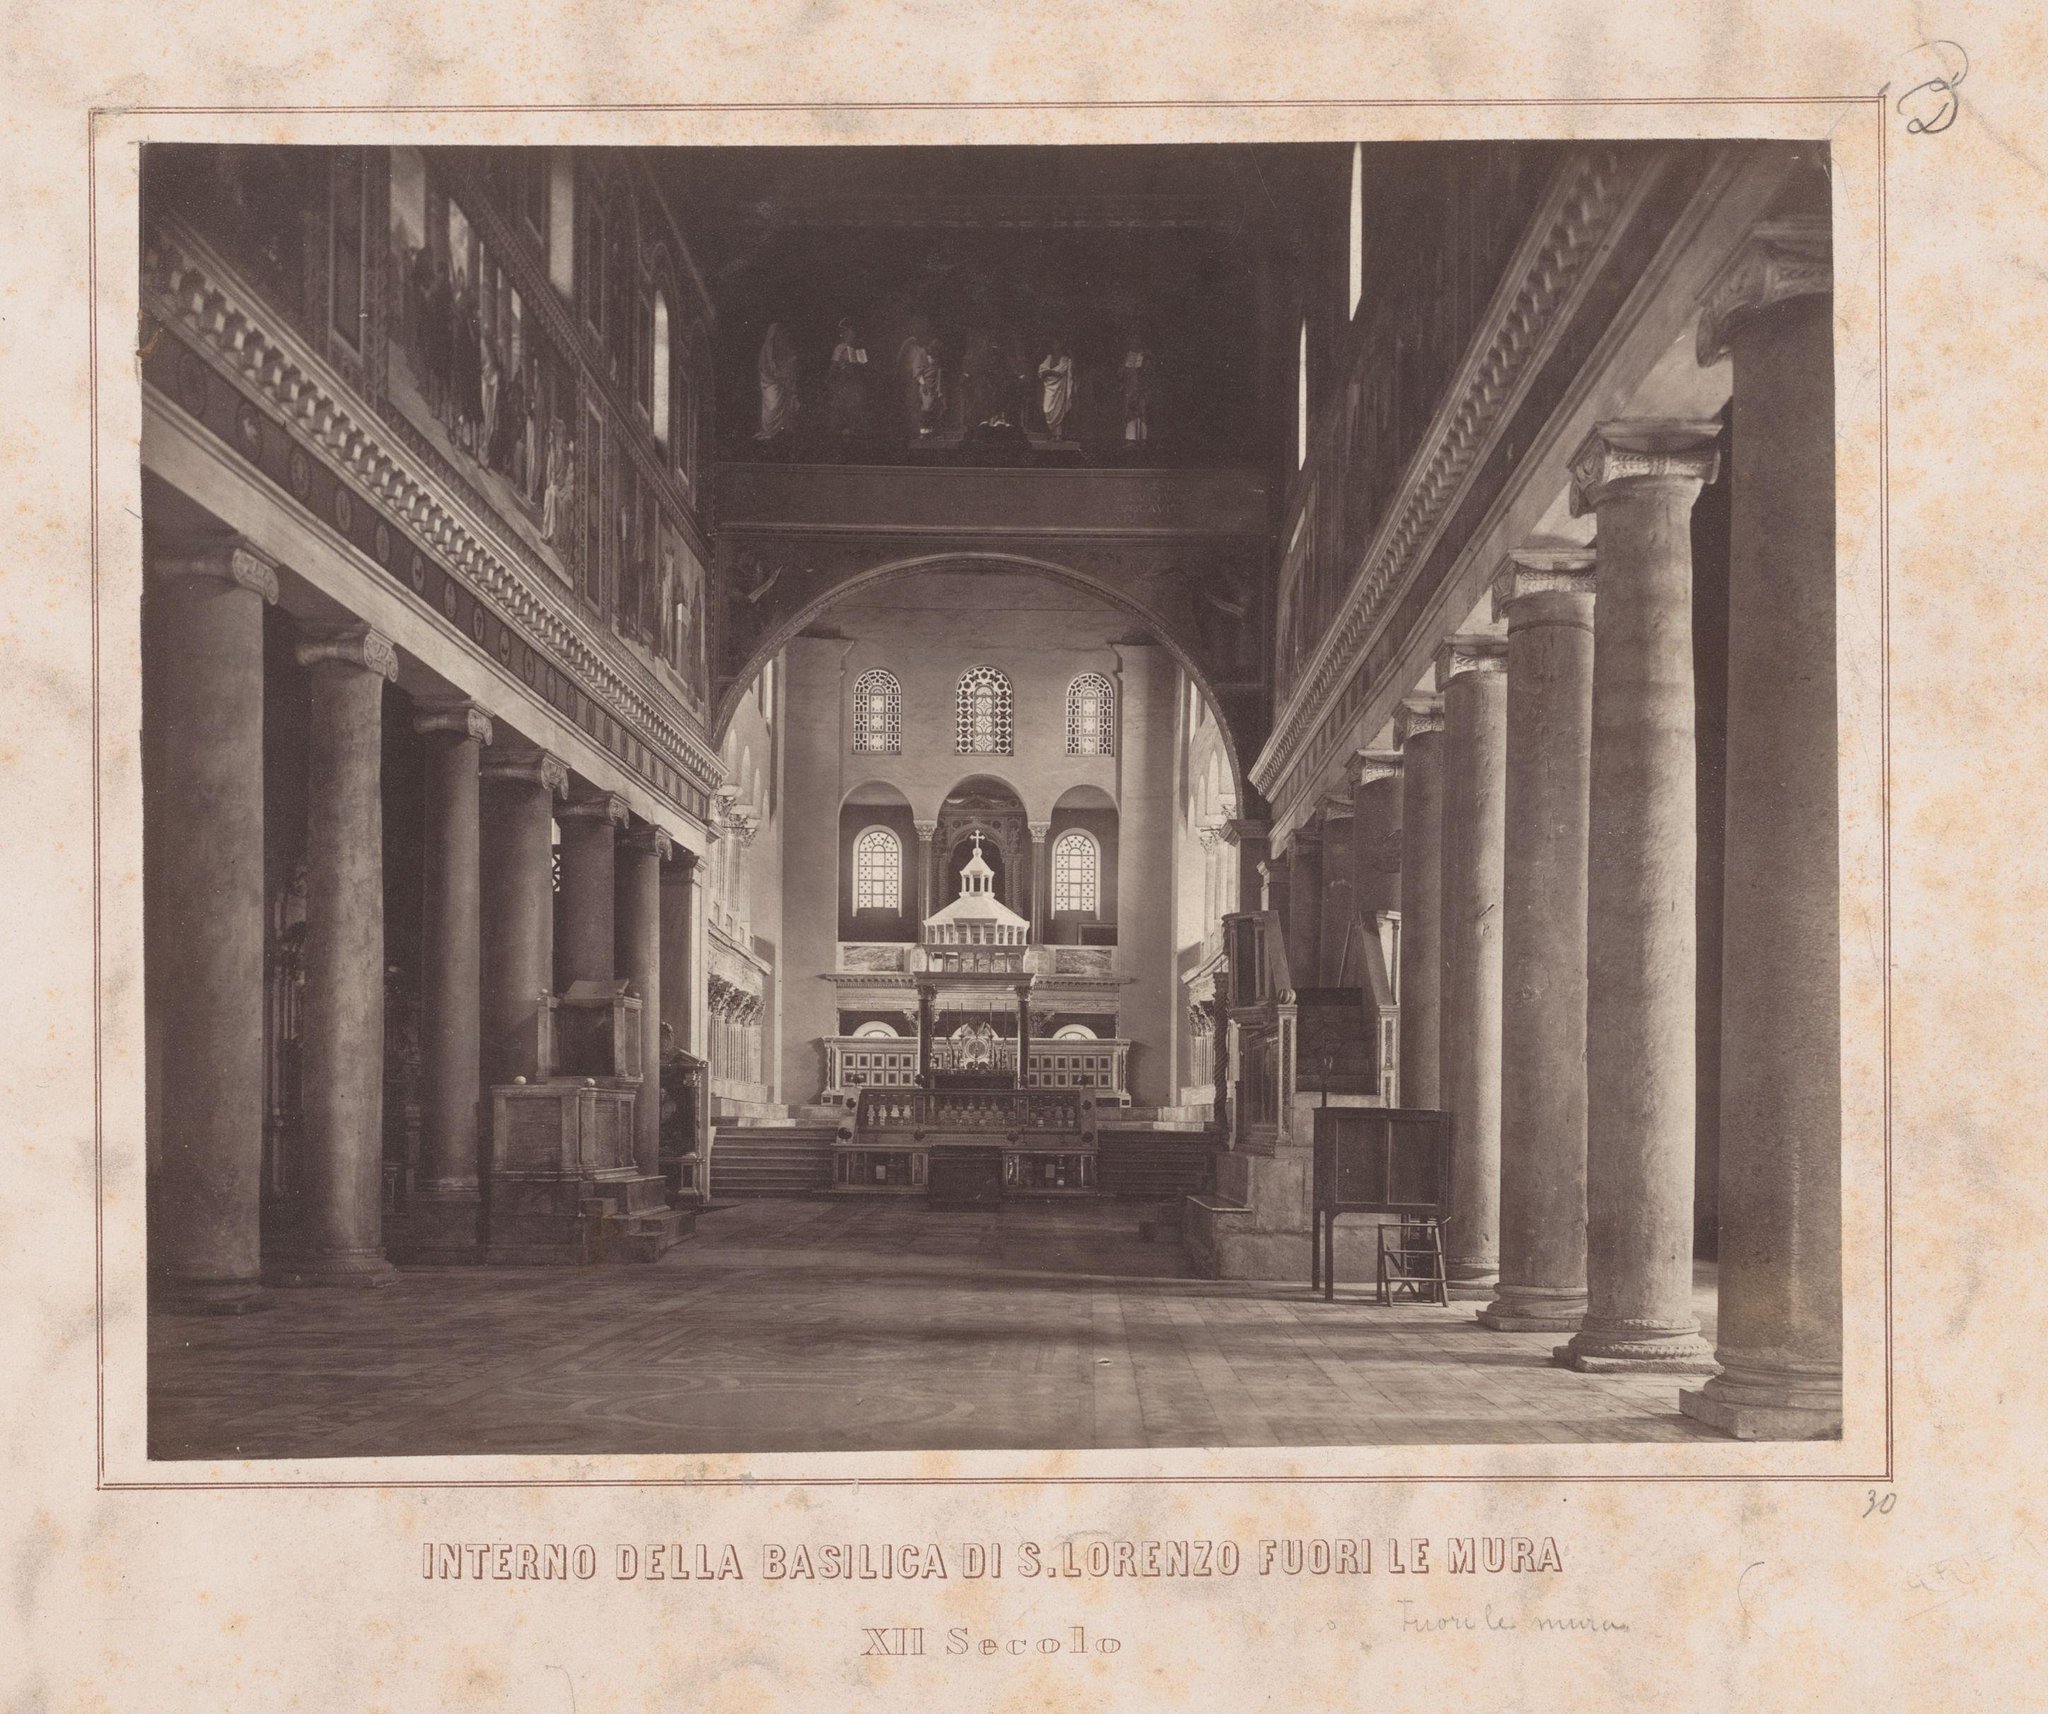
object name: photograph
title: Interieur van de S. Lorenzo fuori le Mura te Rome ('Interno della Basilica di S. Lorenzo fuori le Mura. XII Secolo')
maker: Anonymous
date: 1865-1885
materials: cardboard, paper, photographic support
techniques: albumen print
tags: sint-laurens buiten de muren